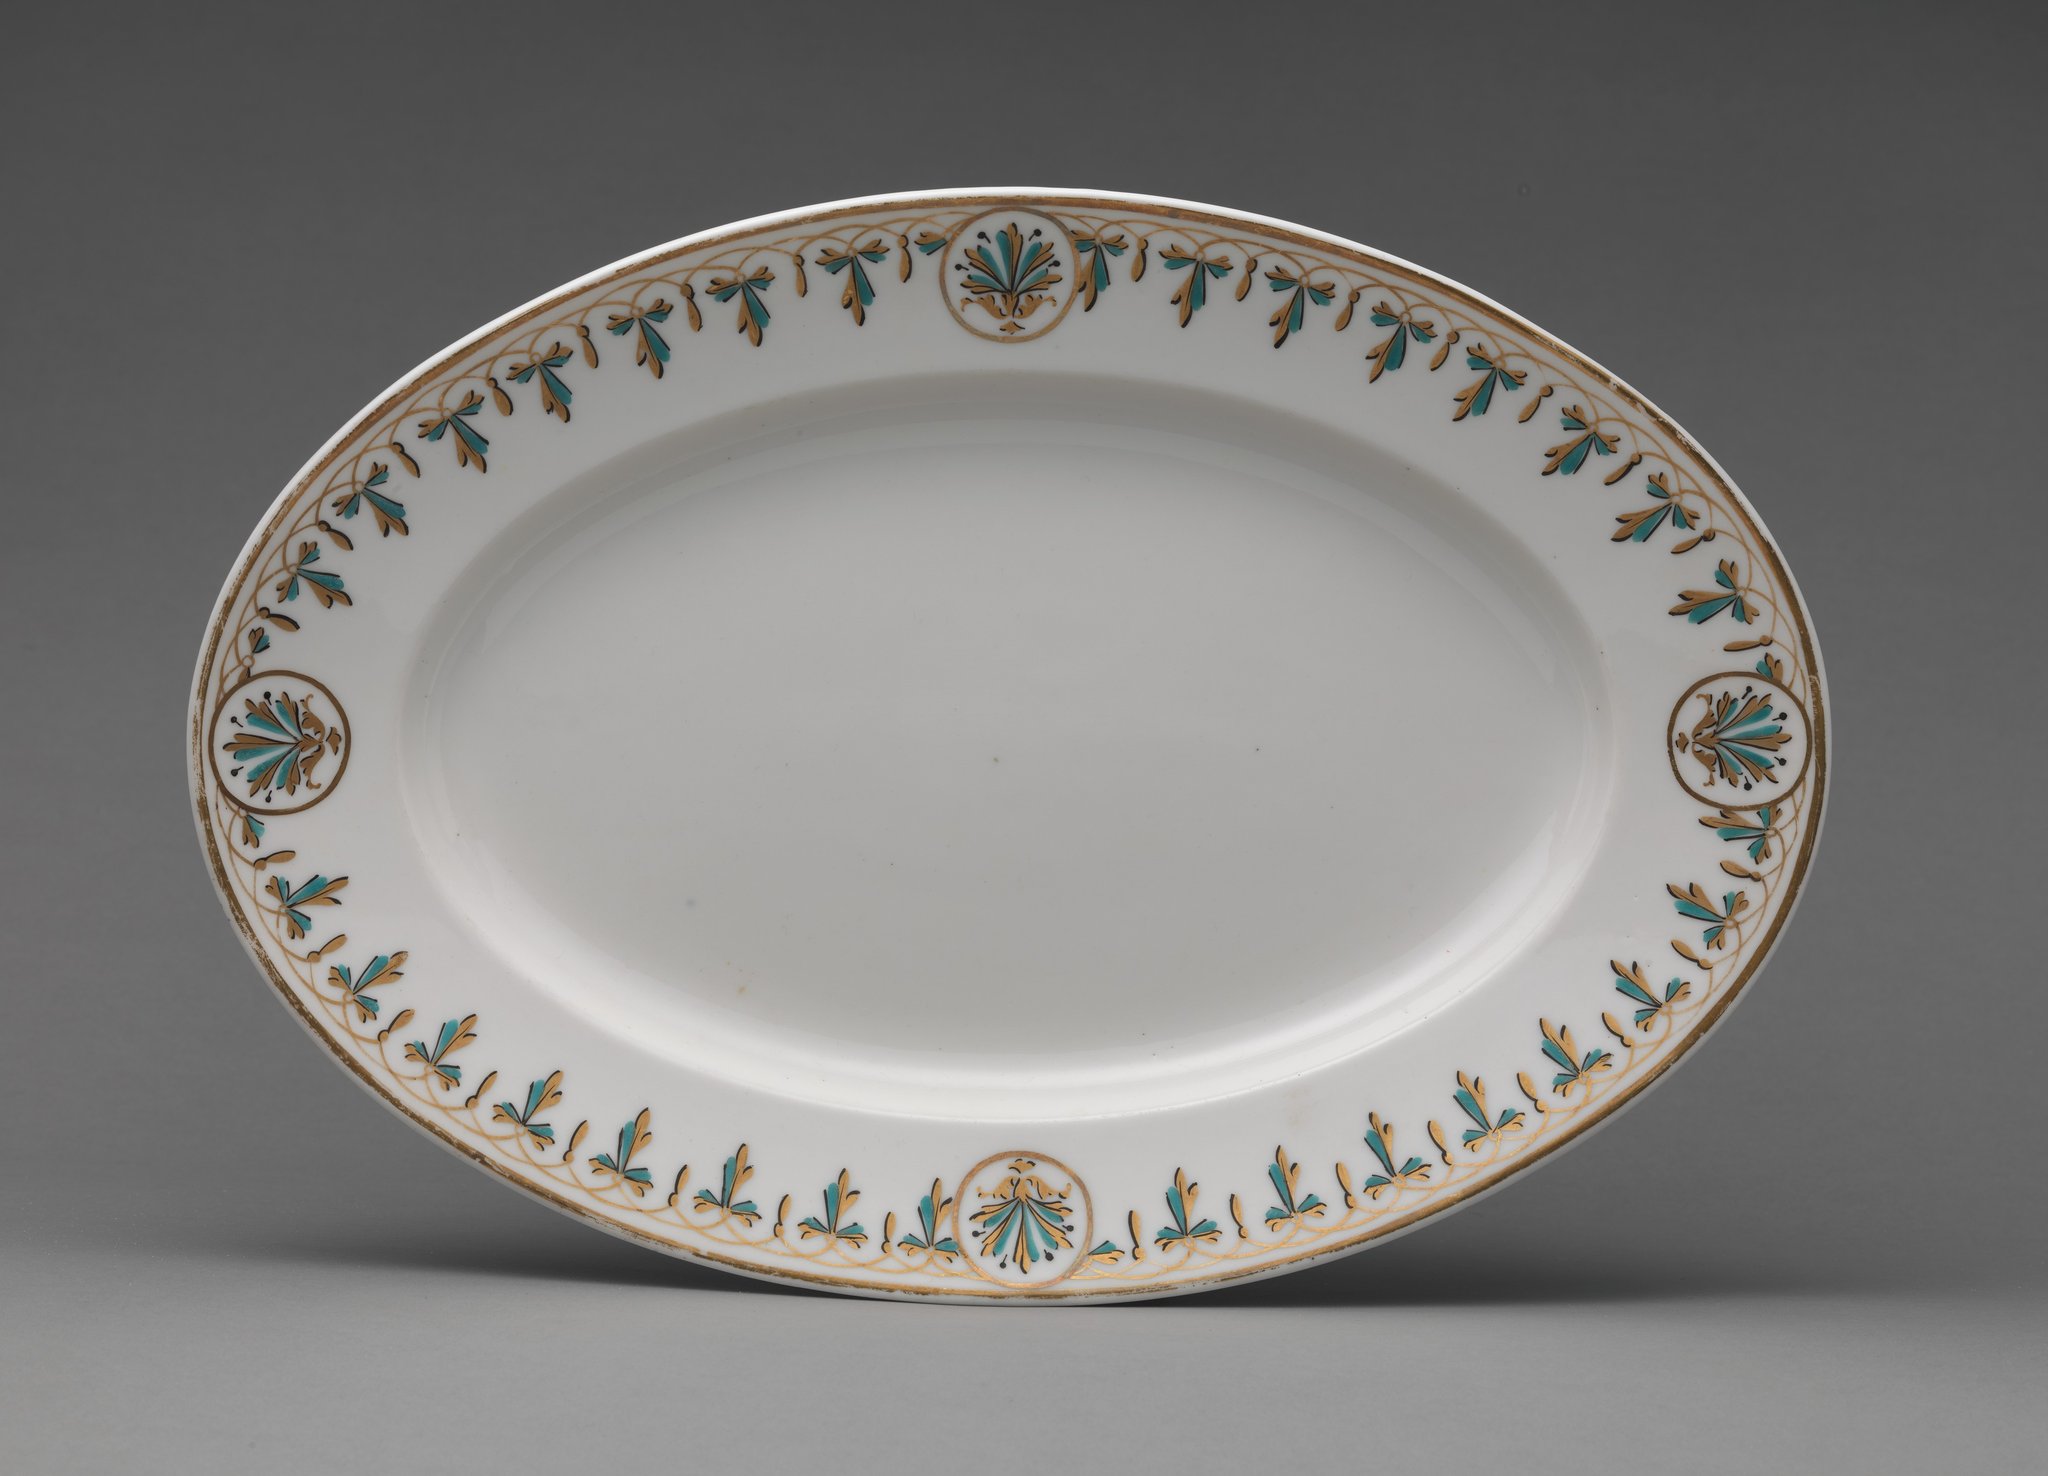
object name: platter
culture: american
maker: union porcelain works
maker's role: maker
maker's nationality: american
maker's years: 1863-1922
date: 1885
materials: porcelain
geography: united states